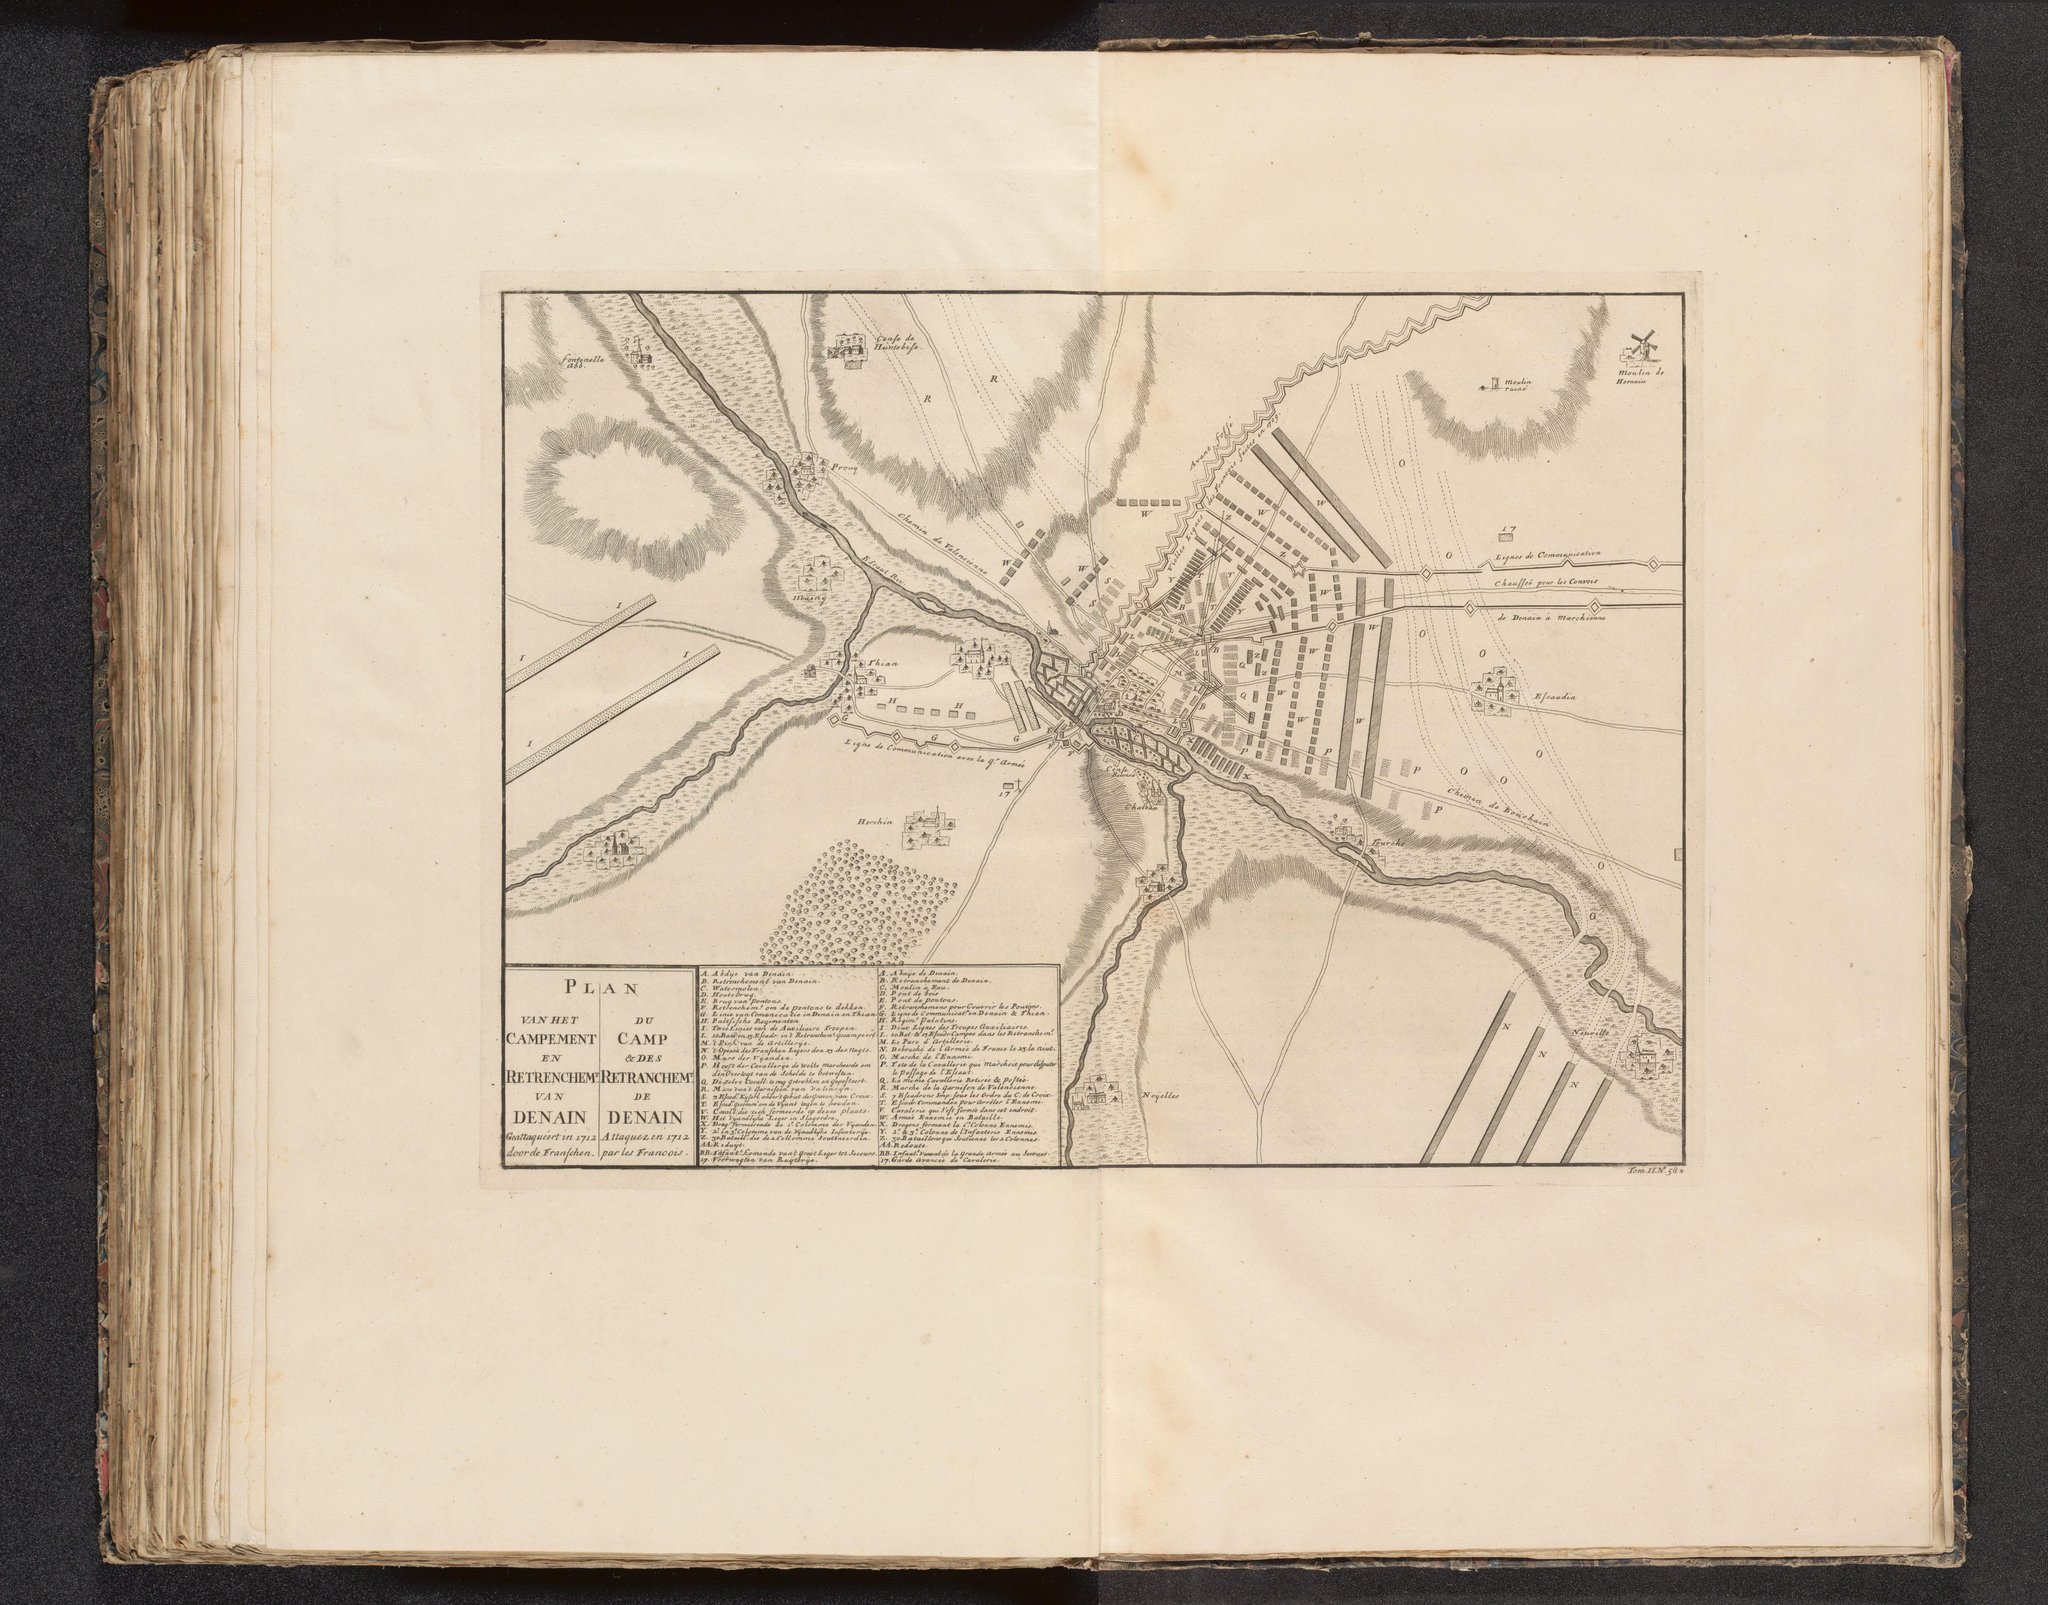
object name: map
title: Plan van het Campement en Retrenchemt. van Dedain Geattaqueert in 1712 door de Franschen / [Plan] du Camp & des Retranchemt. (...)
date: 1712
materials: paper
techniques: etching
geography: northern netherlands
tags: paris, vienna, eugenius van savoye, (military) camp with tents, maps of cities, battle (+ land forces)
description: Kaart van de legerkamp van de Geallieerden bij Denain, aangevallen door de Fransen op 24 juli 1712. Genummerd rechtsonder: Tom. II. No. 58*. Illustratie in het tweede deel van : [Jean] du Mont, Oorlogskundige beschryving van de veldslagen en belegeringen, der drie ... wydvermaarde krygsoversten... den Prins Eugenius van Savoye, den ... Hertog van Marlborough, en den Prins van Oranje en Nassau-Vriesland, in de editie van 1729. Dit tweede deel is hoofdzakelijk gewijd aan de daden van de hertog van Marlborough en prins Johan Willem Friso.